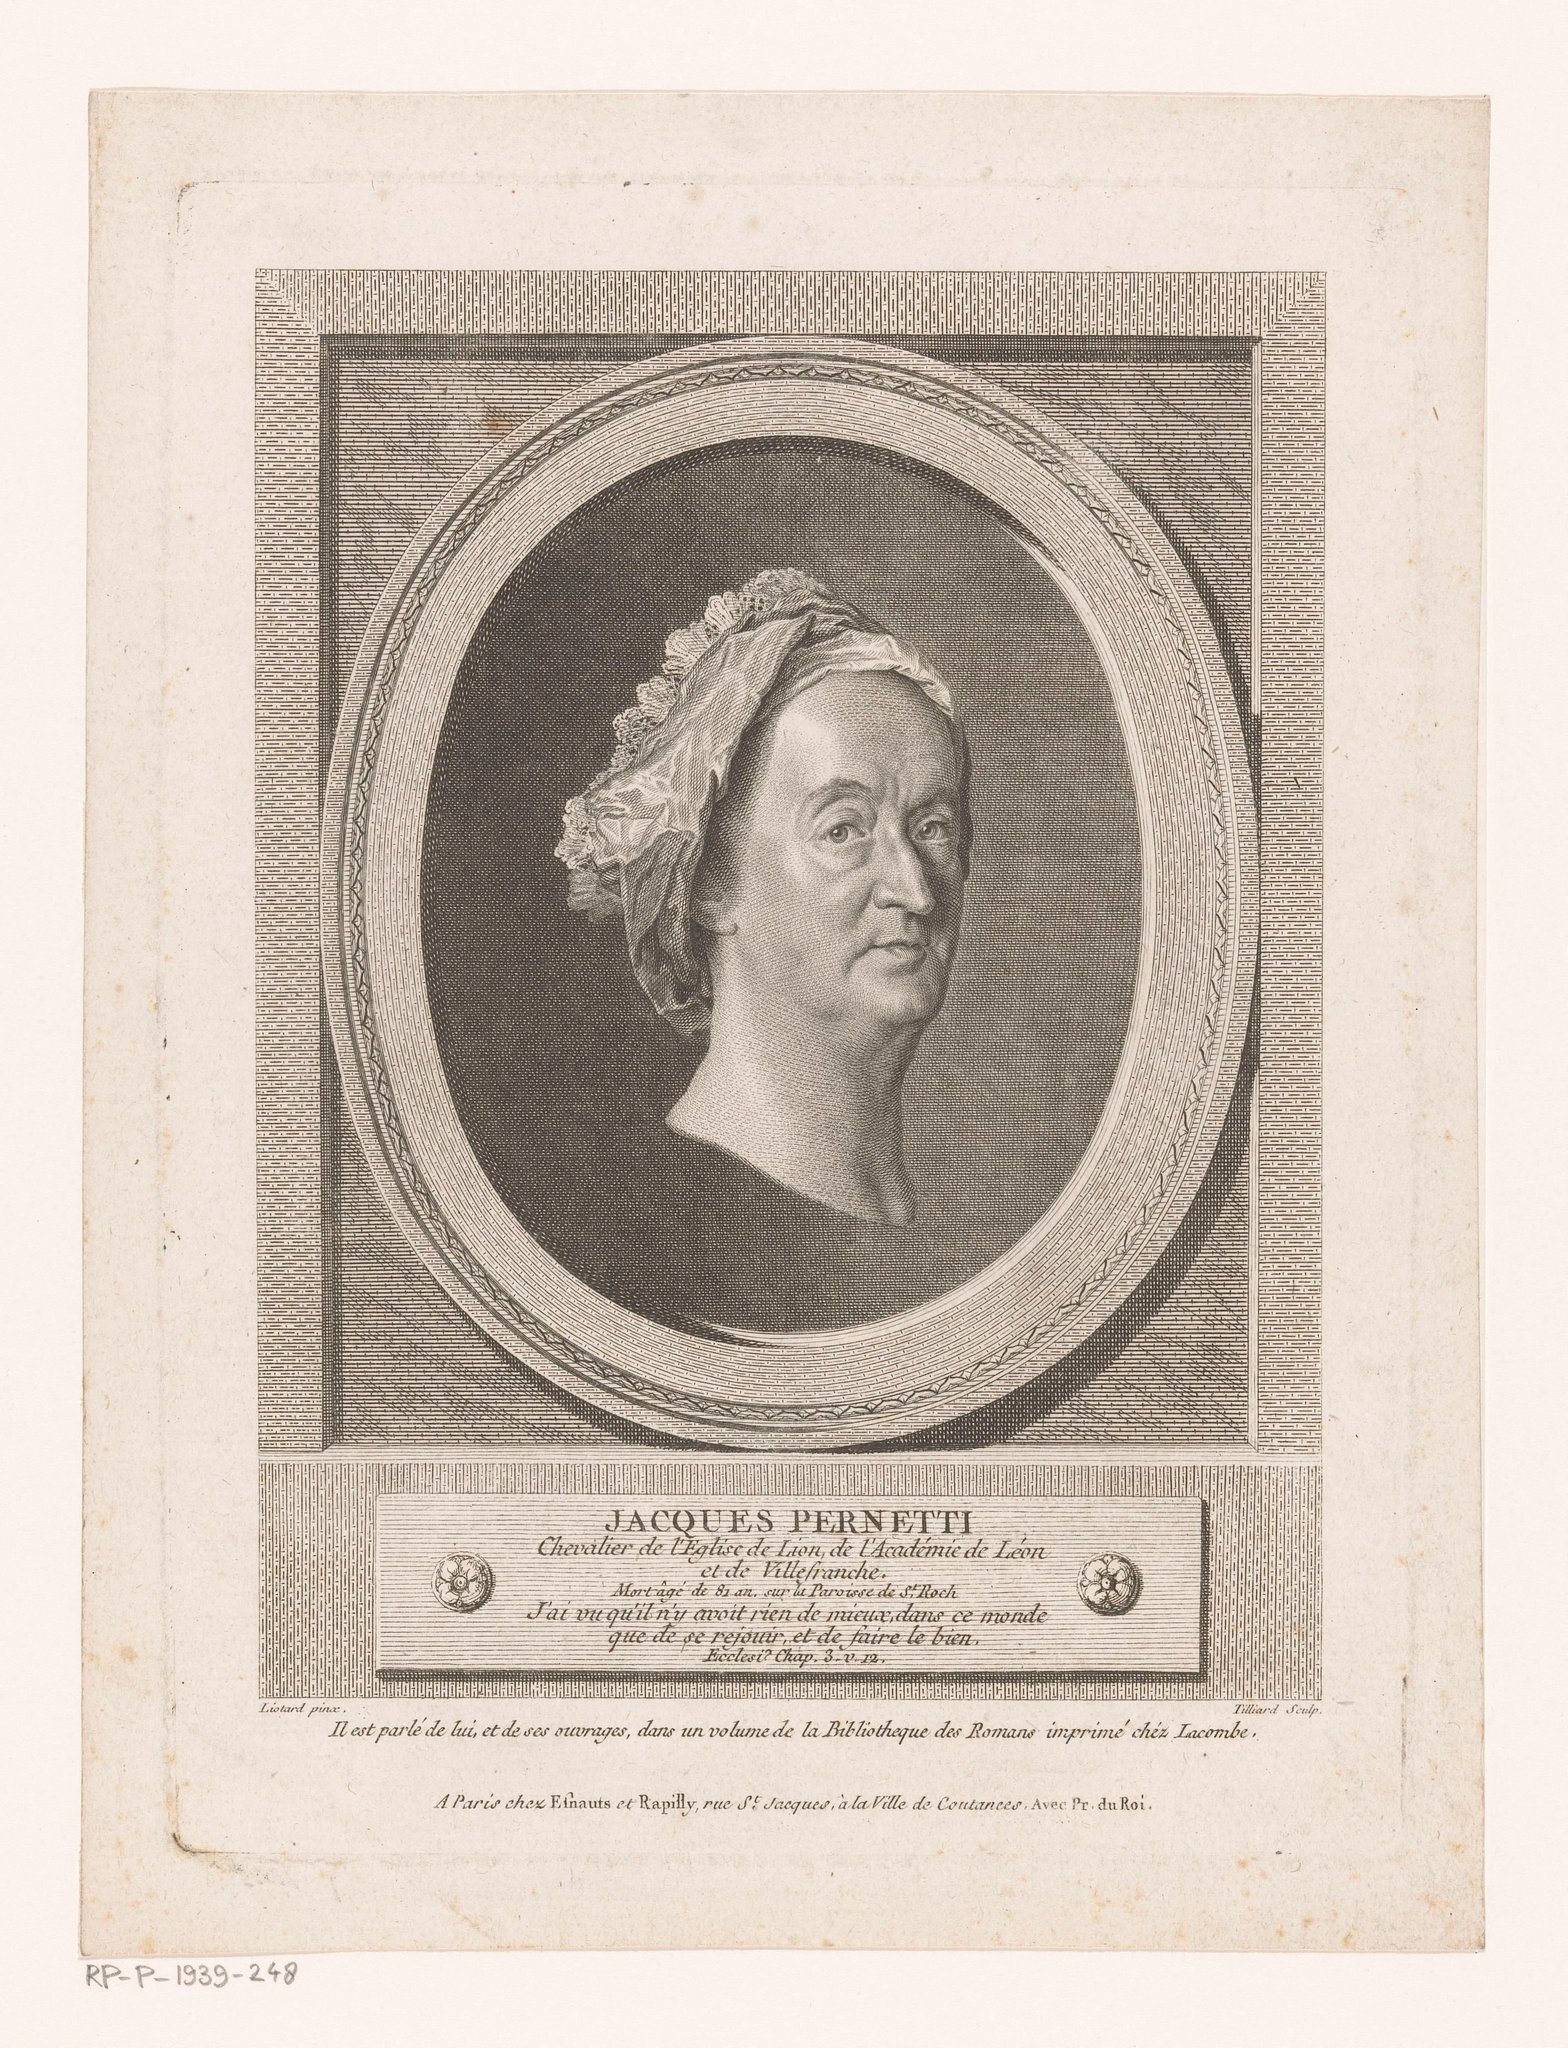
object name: print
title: Portret van Jacques Pernetti in ovaal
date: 1750-1813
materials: paper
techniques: engraving, etching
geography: france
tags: lyon, historical persons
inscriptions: collector's mark: Lugt 2760, collector's mark: Lugt 2228